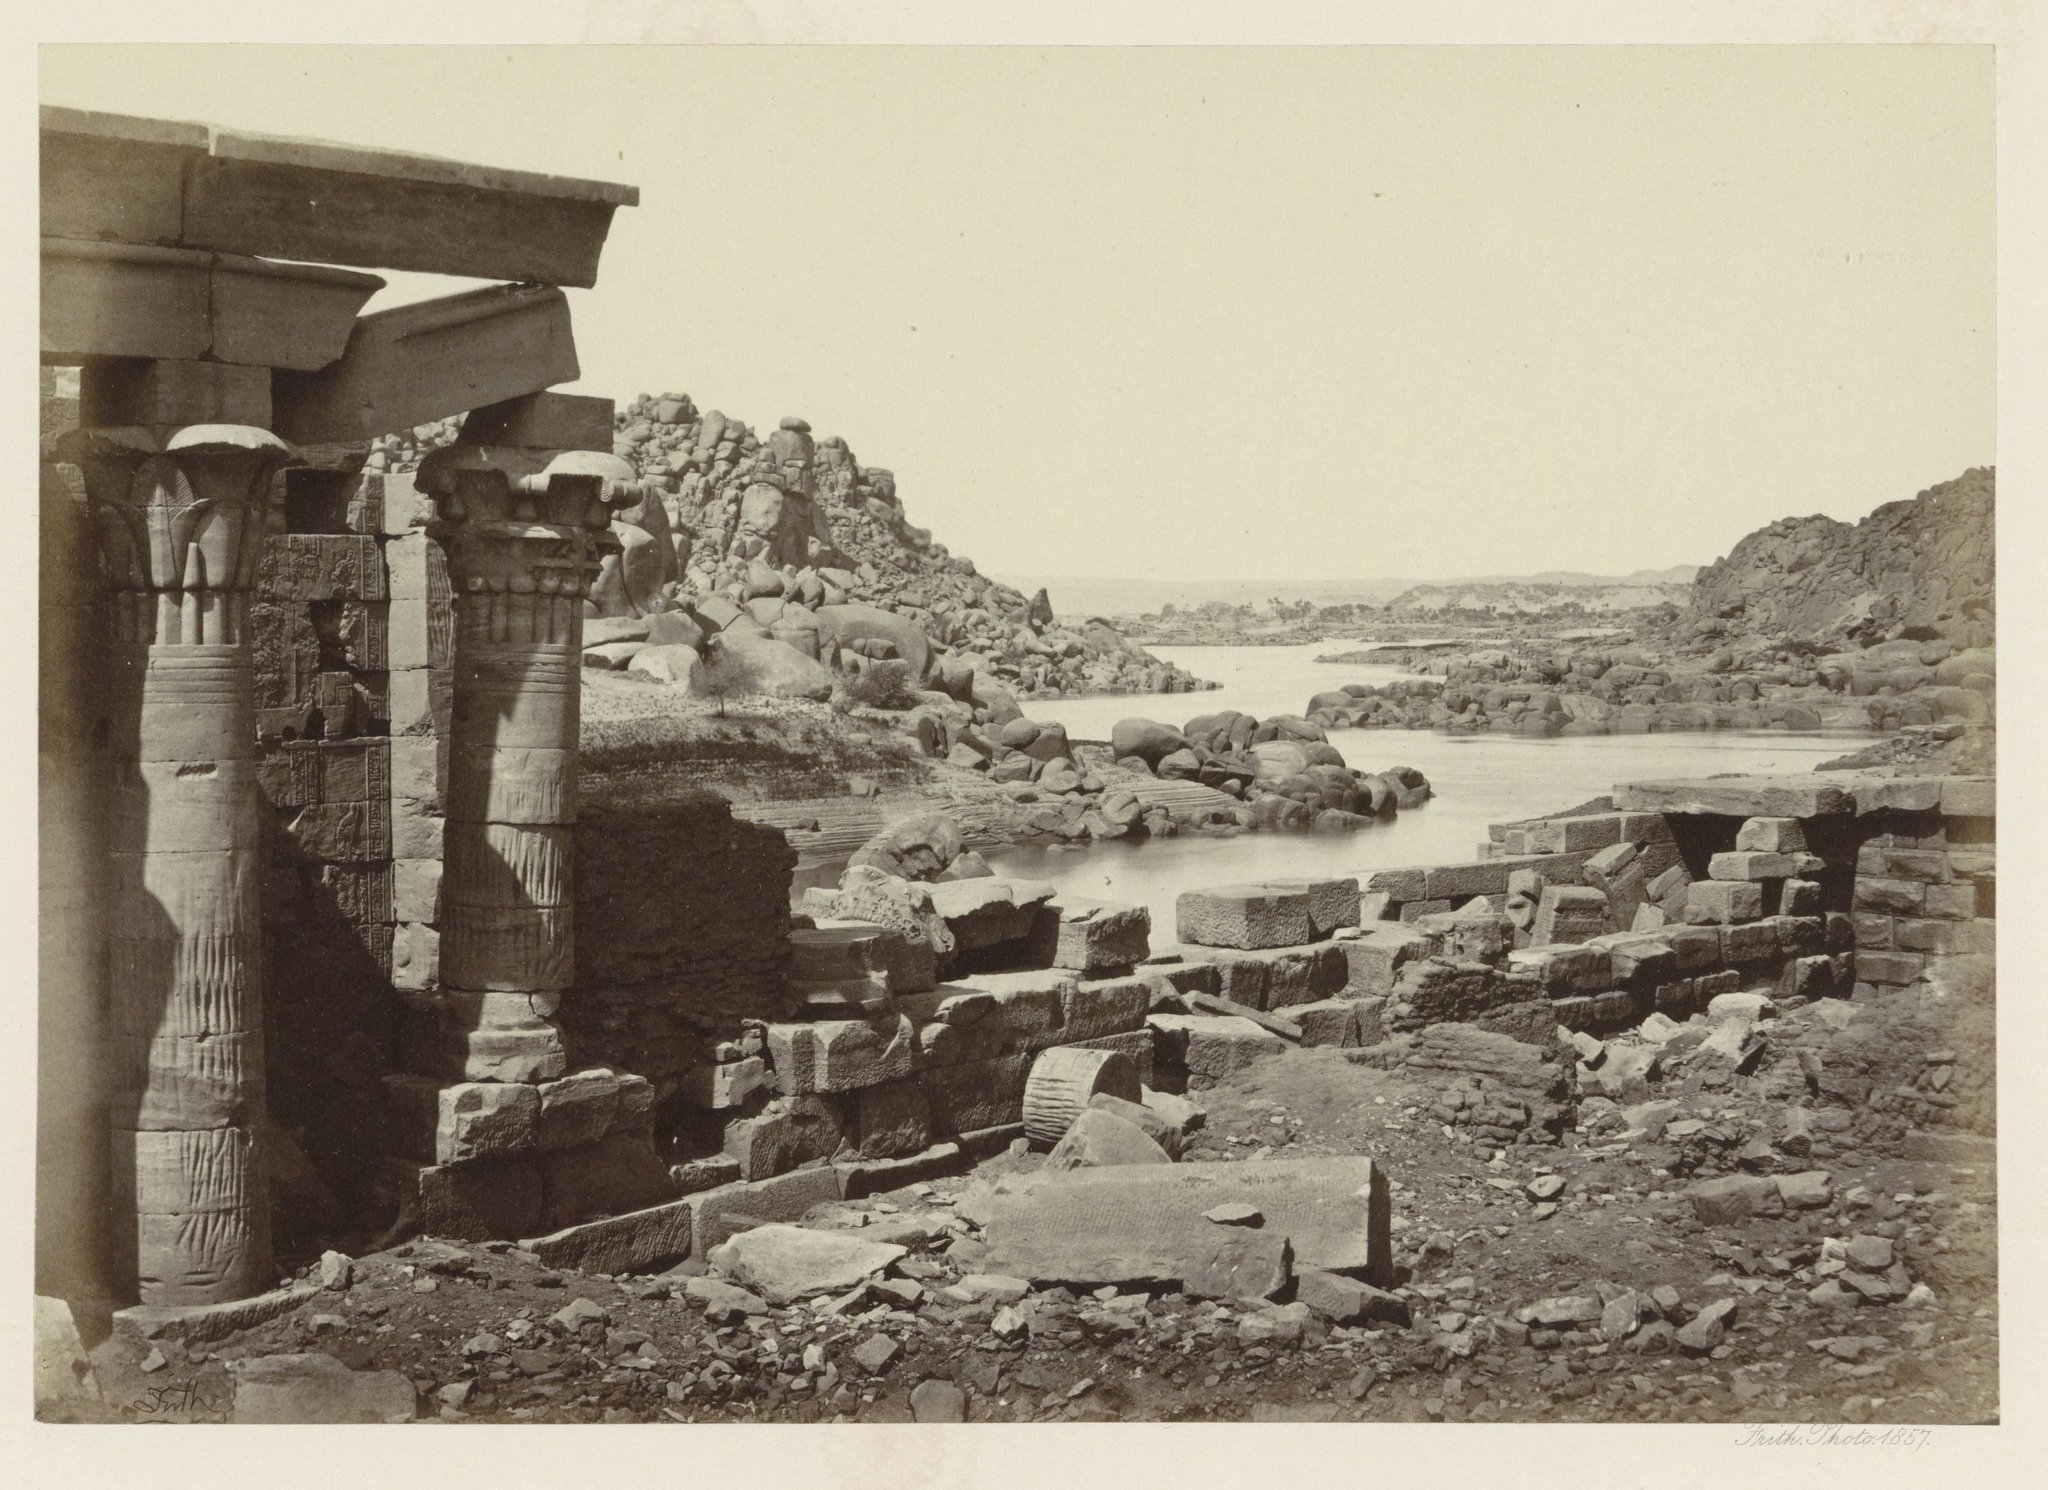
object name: page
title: View from Philae - Looking North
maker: francis frith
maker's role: publisher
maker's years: 1822-1898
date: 1857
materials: paper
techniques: albumen print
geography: philae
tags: island, temple, shrine ~ egyptian religion, river